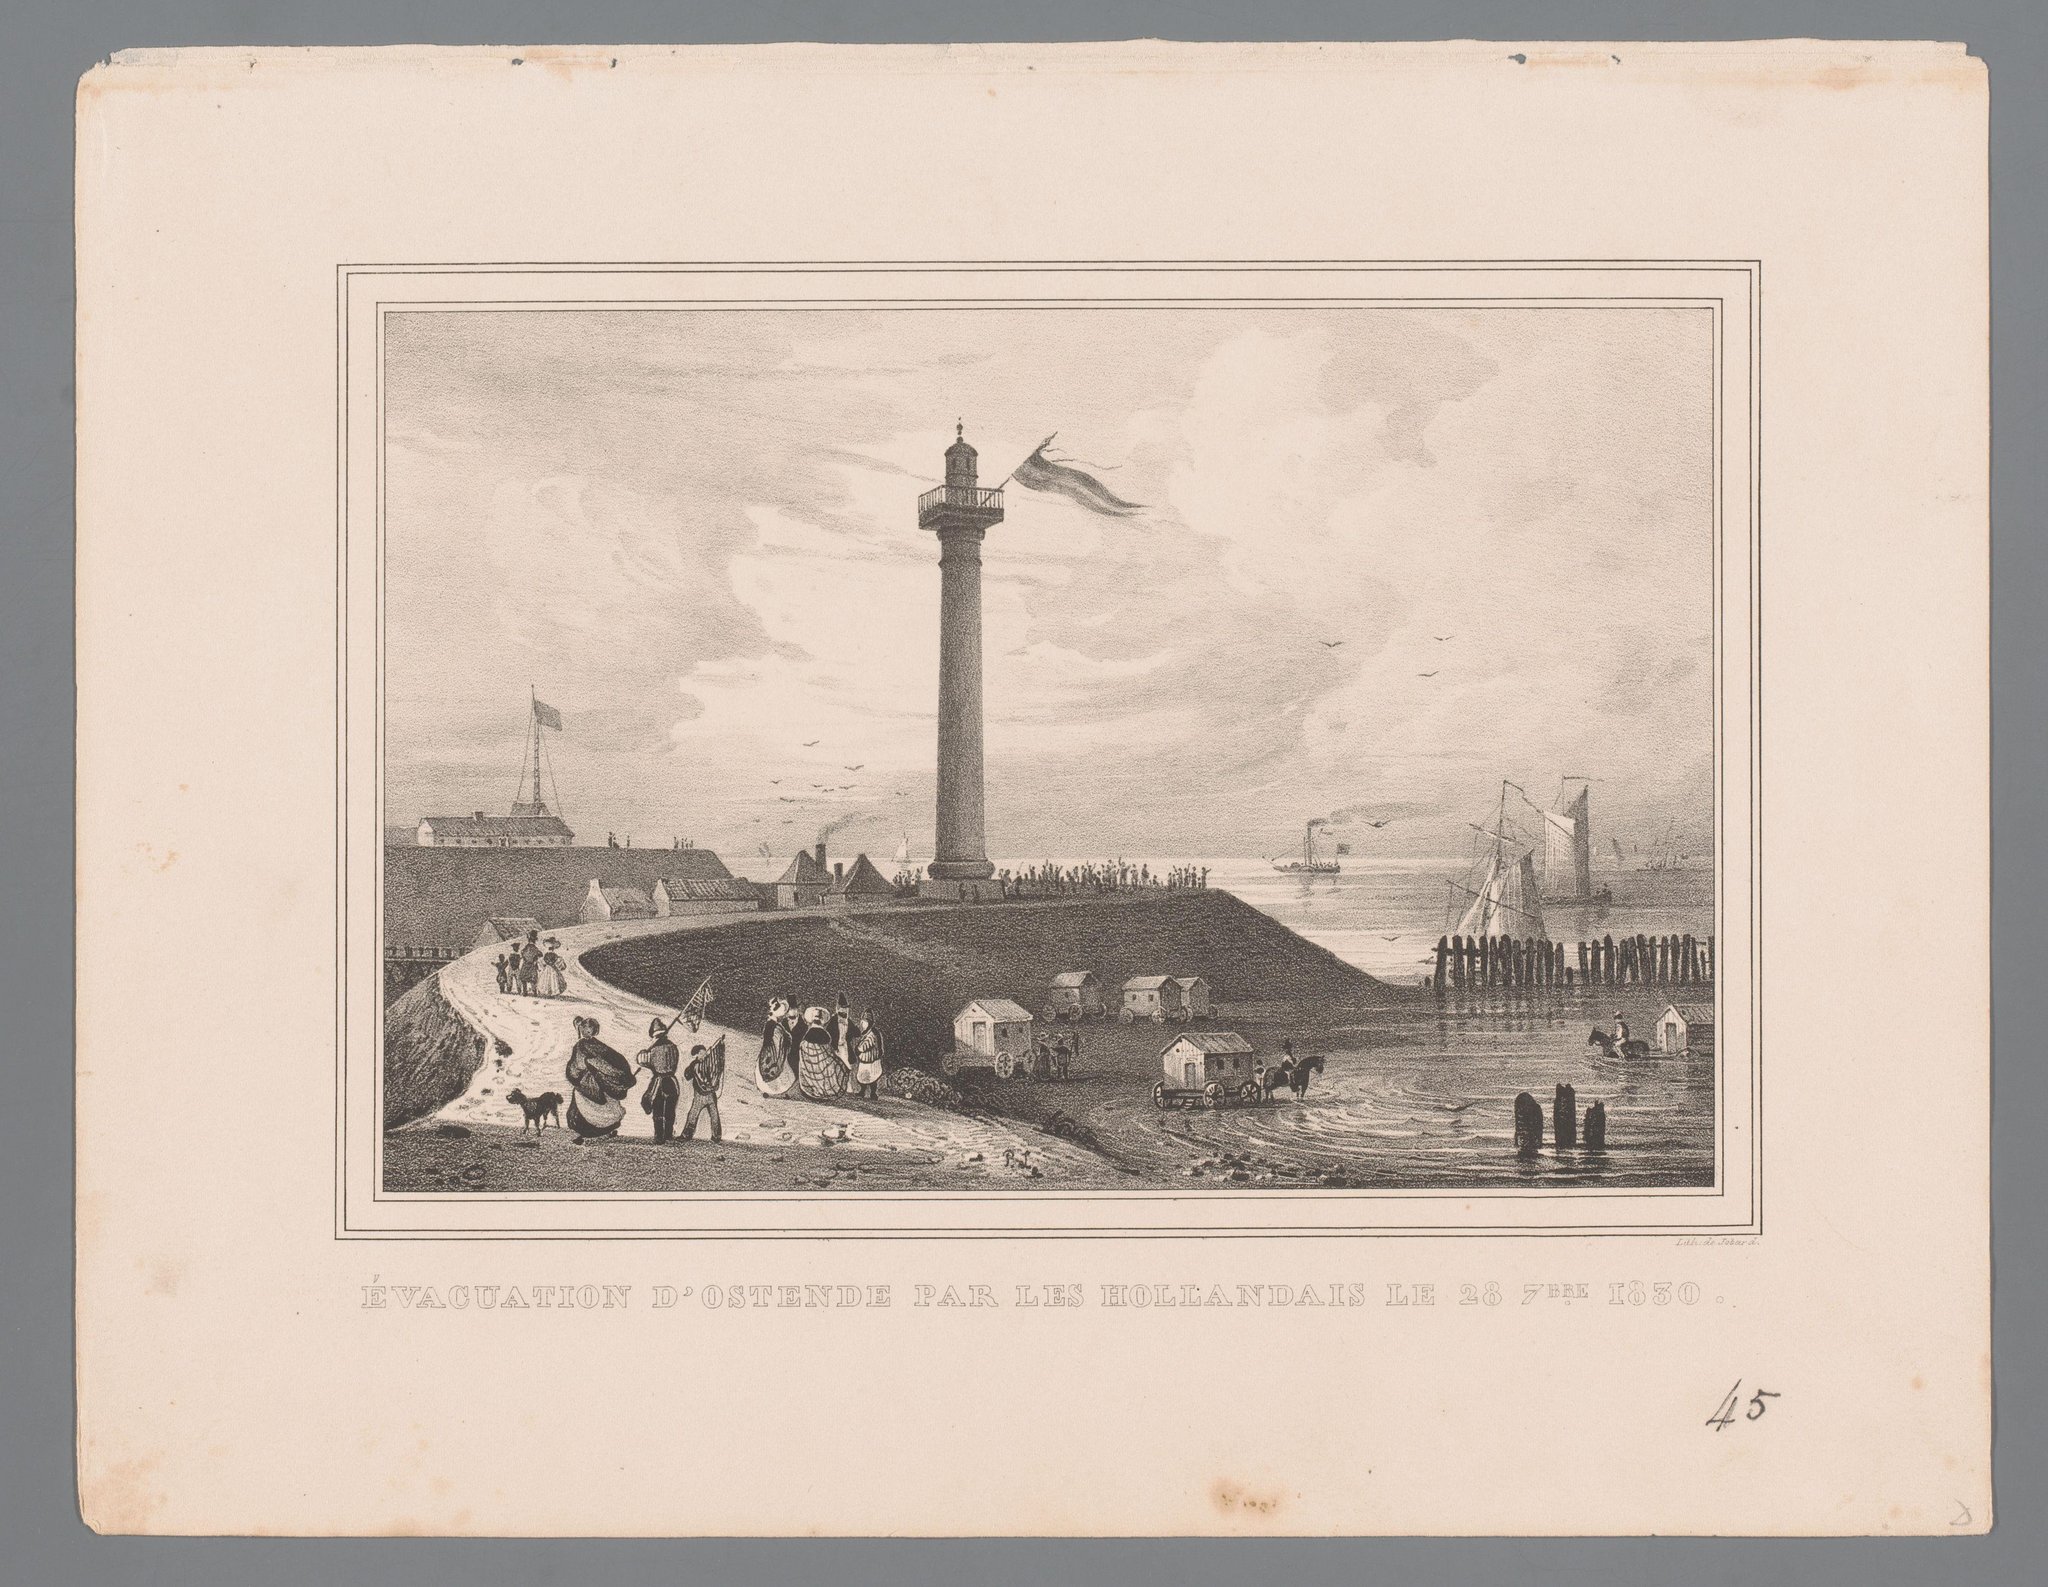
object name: print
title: Nederlandse troepen verlaten Oostende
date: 1830-1831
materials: paper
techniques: lithograph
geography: brussels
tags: transport, train (military)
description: Prent maakt deel uit van een serie met prenten over de gebeurtenissen tijdens de Belgische Revolutie in Brussel, Antwerpen en andere steden in de periode 25 augustus 1830 tot 27 maart 1831.